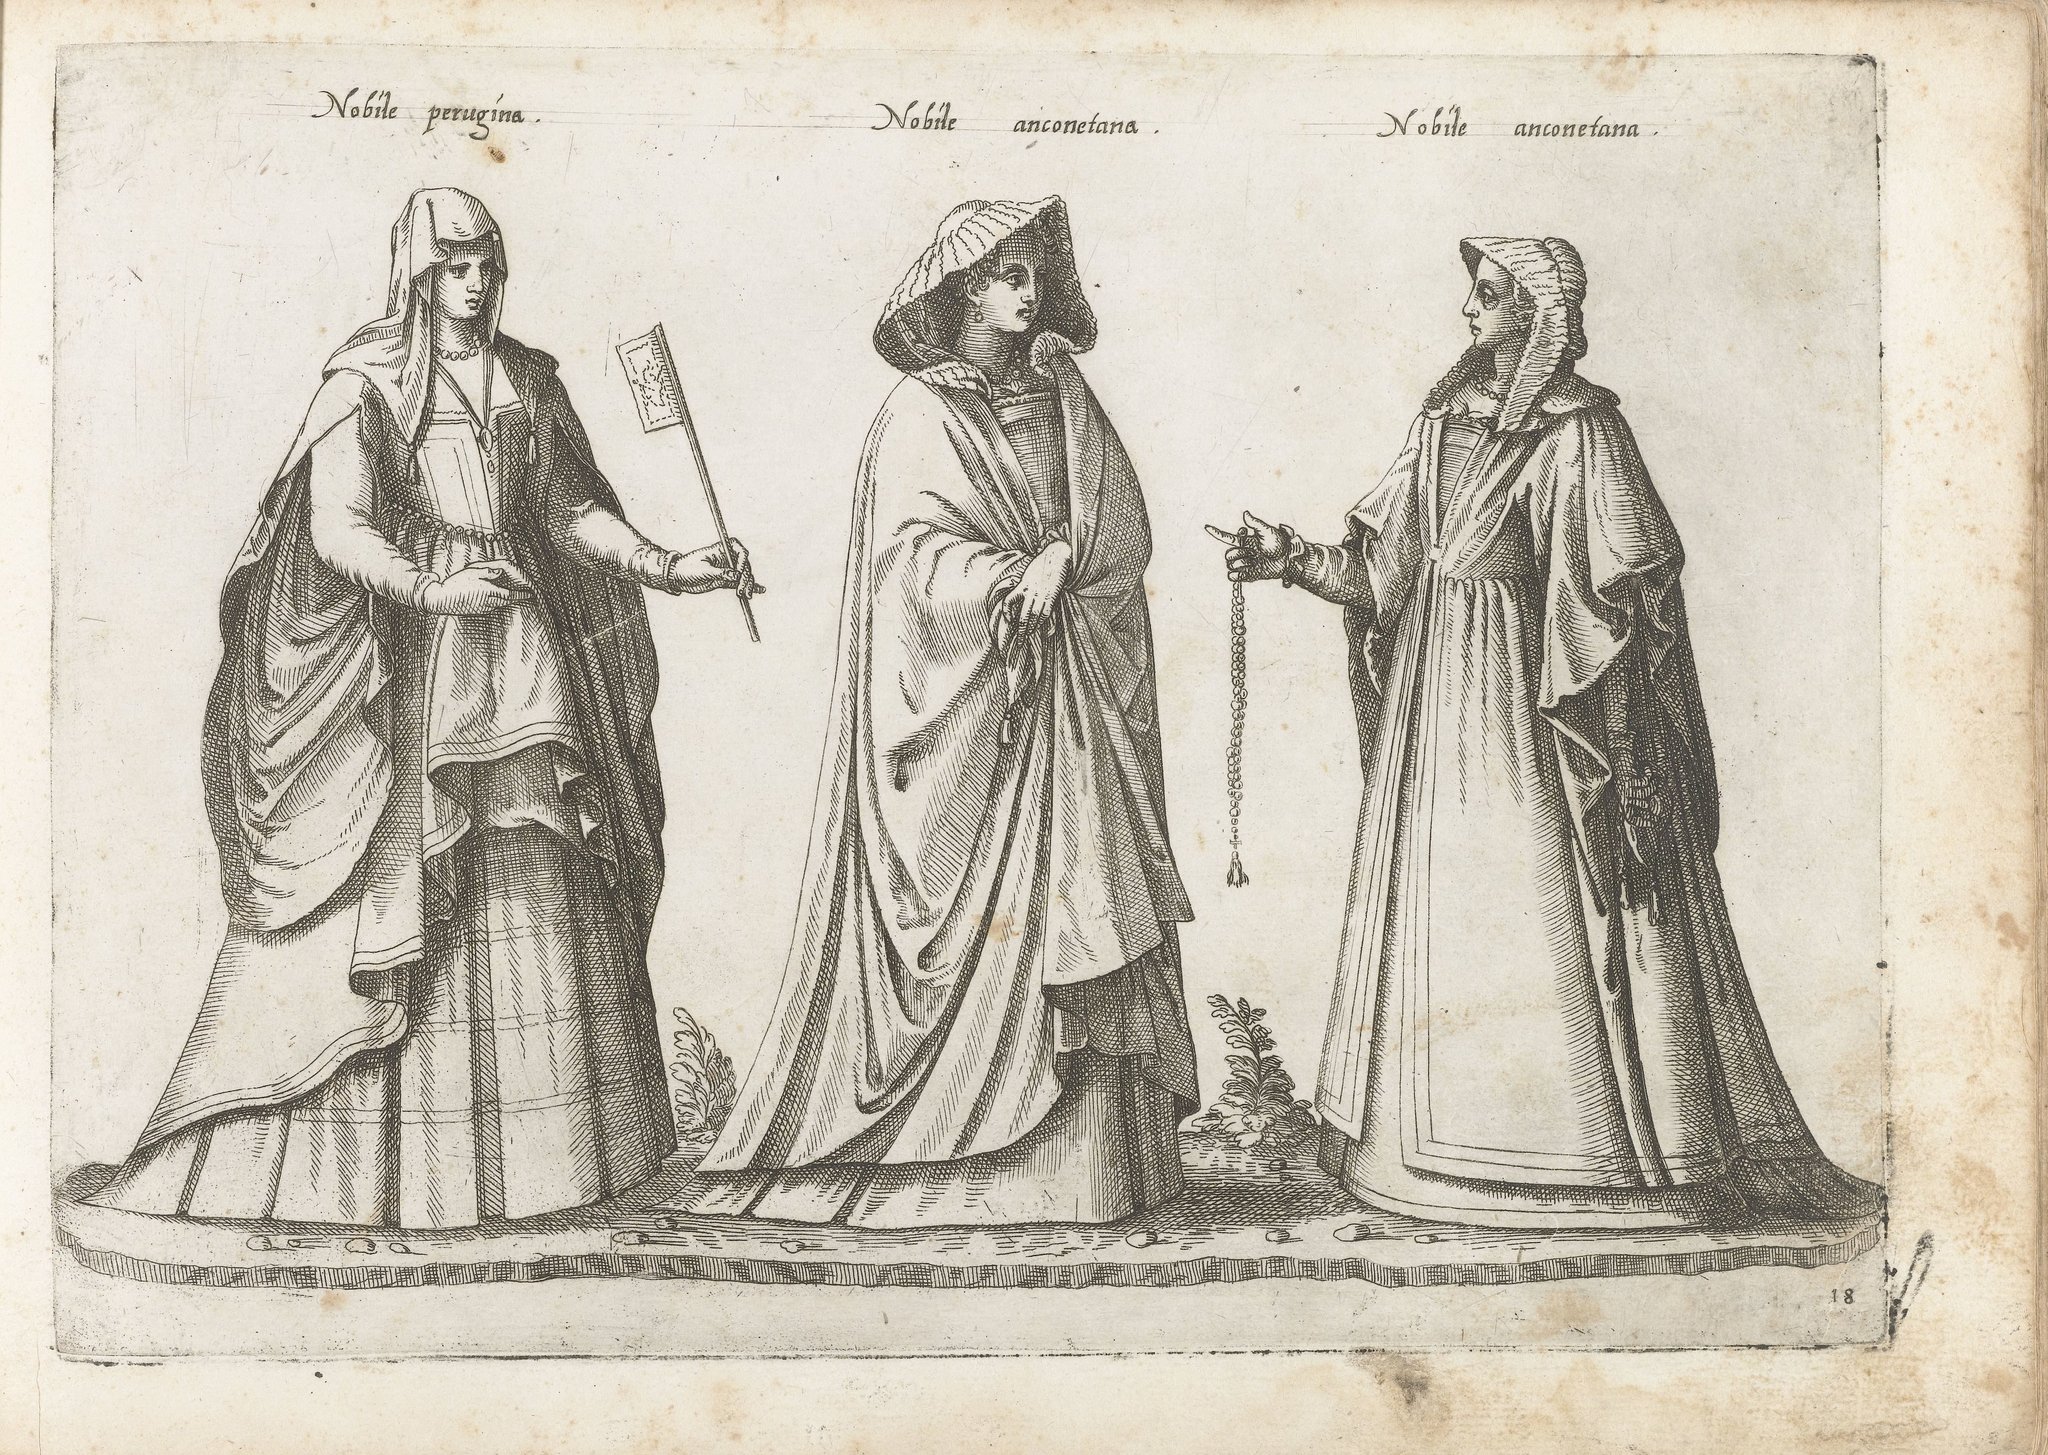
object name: costume print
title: Drie vrouwen, gekleed volgens de mode van Perugia en Ancona, ca. 1580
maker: bartolomeo grassi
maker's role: publisher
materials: paper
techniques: engraving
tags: aids for prayer, e.g. rosary, europeans (with name) (+ costume)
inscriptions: number: ‘17’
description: Prent nr. 18 uit album 'Dei veri ritratti degl'habiti di tvtte le parti del mondo intagliati in rame per opra di Bartolomeo Grassi', 1585.